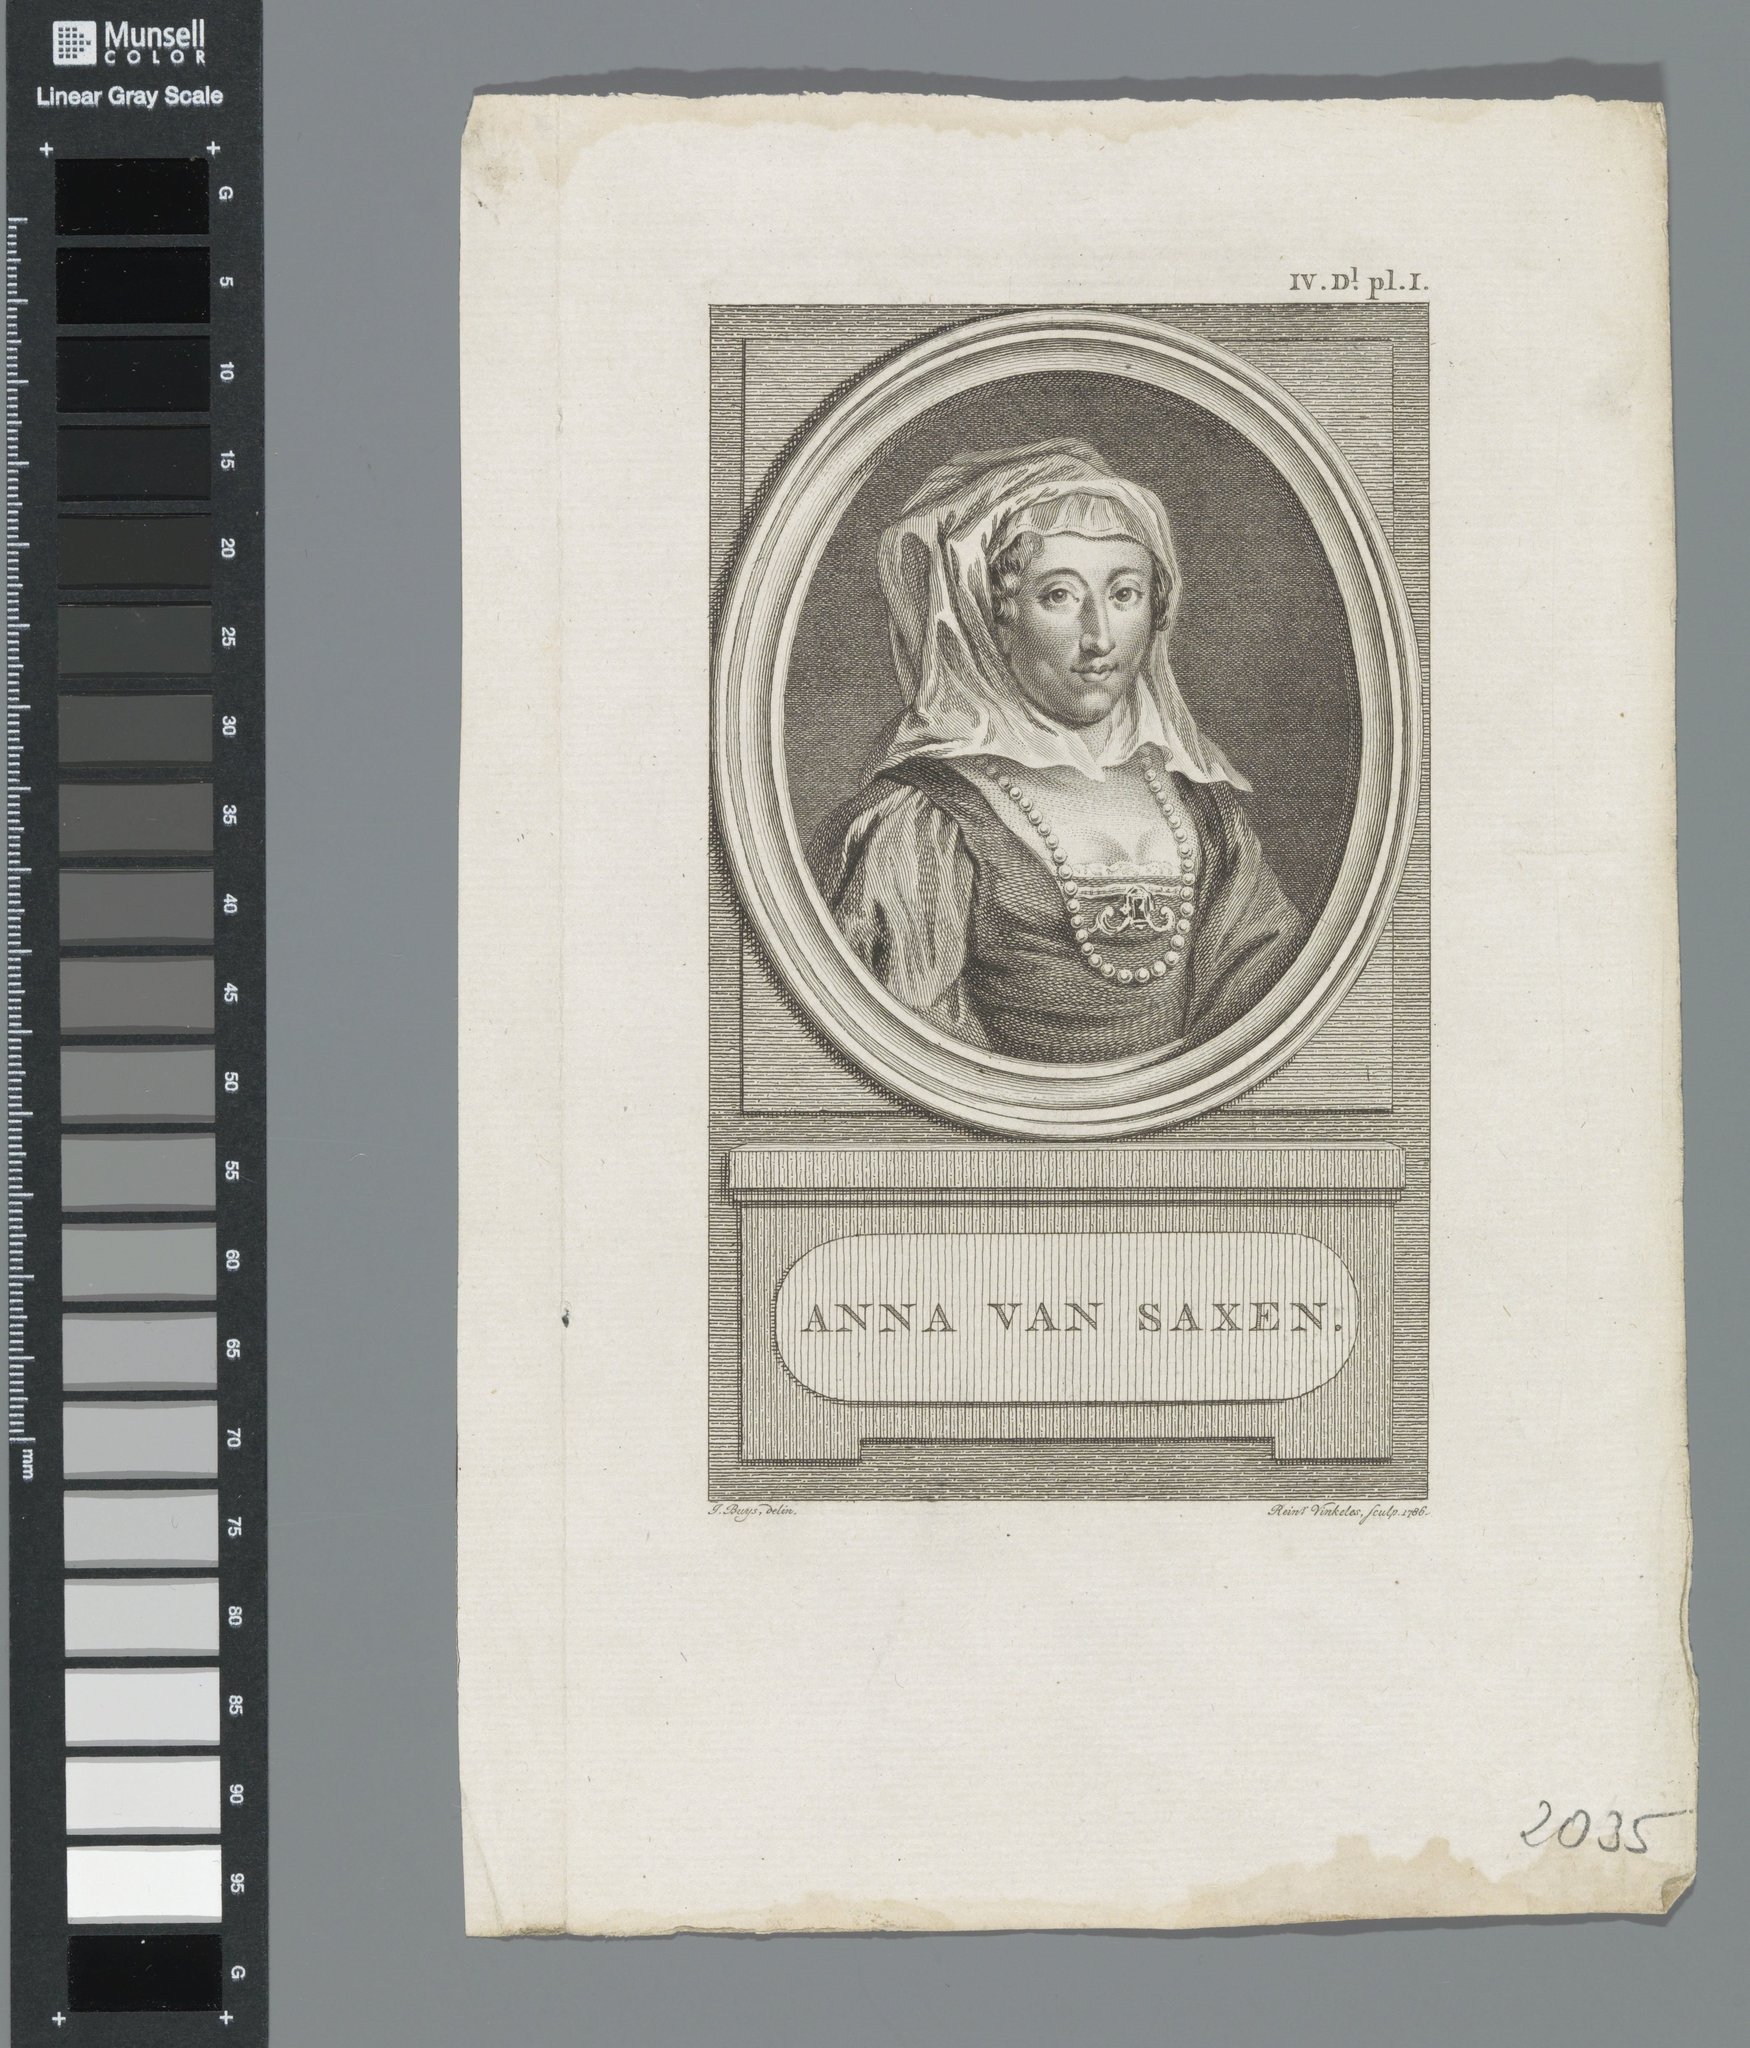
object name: print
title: Portret van Anna van Saksen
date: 1786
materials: paper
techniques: engraving, etching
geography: amsterdam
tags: dresden, anna van saksen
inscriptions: date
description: Portret van Anna in een ovaal. In een kader haar naam. Rechtsboven 'IV. Dl. pl. I.'.